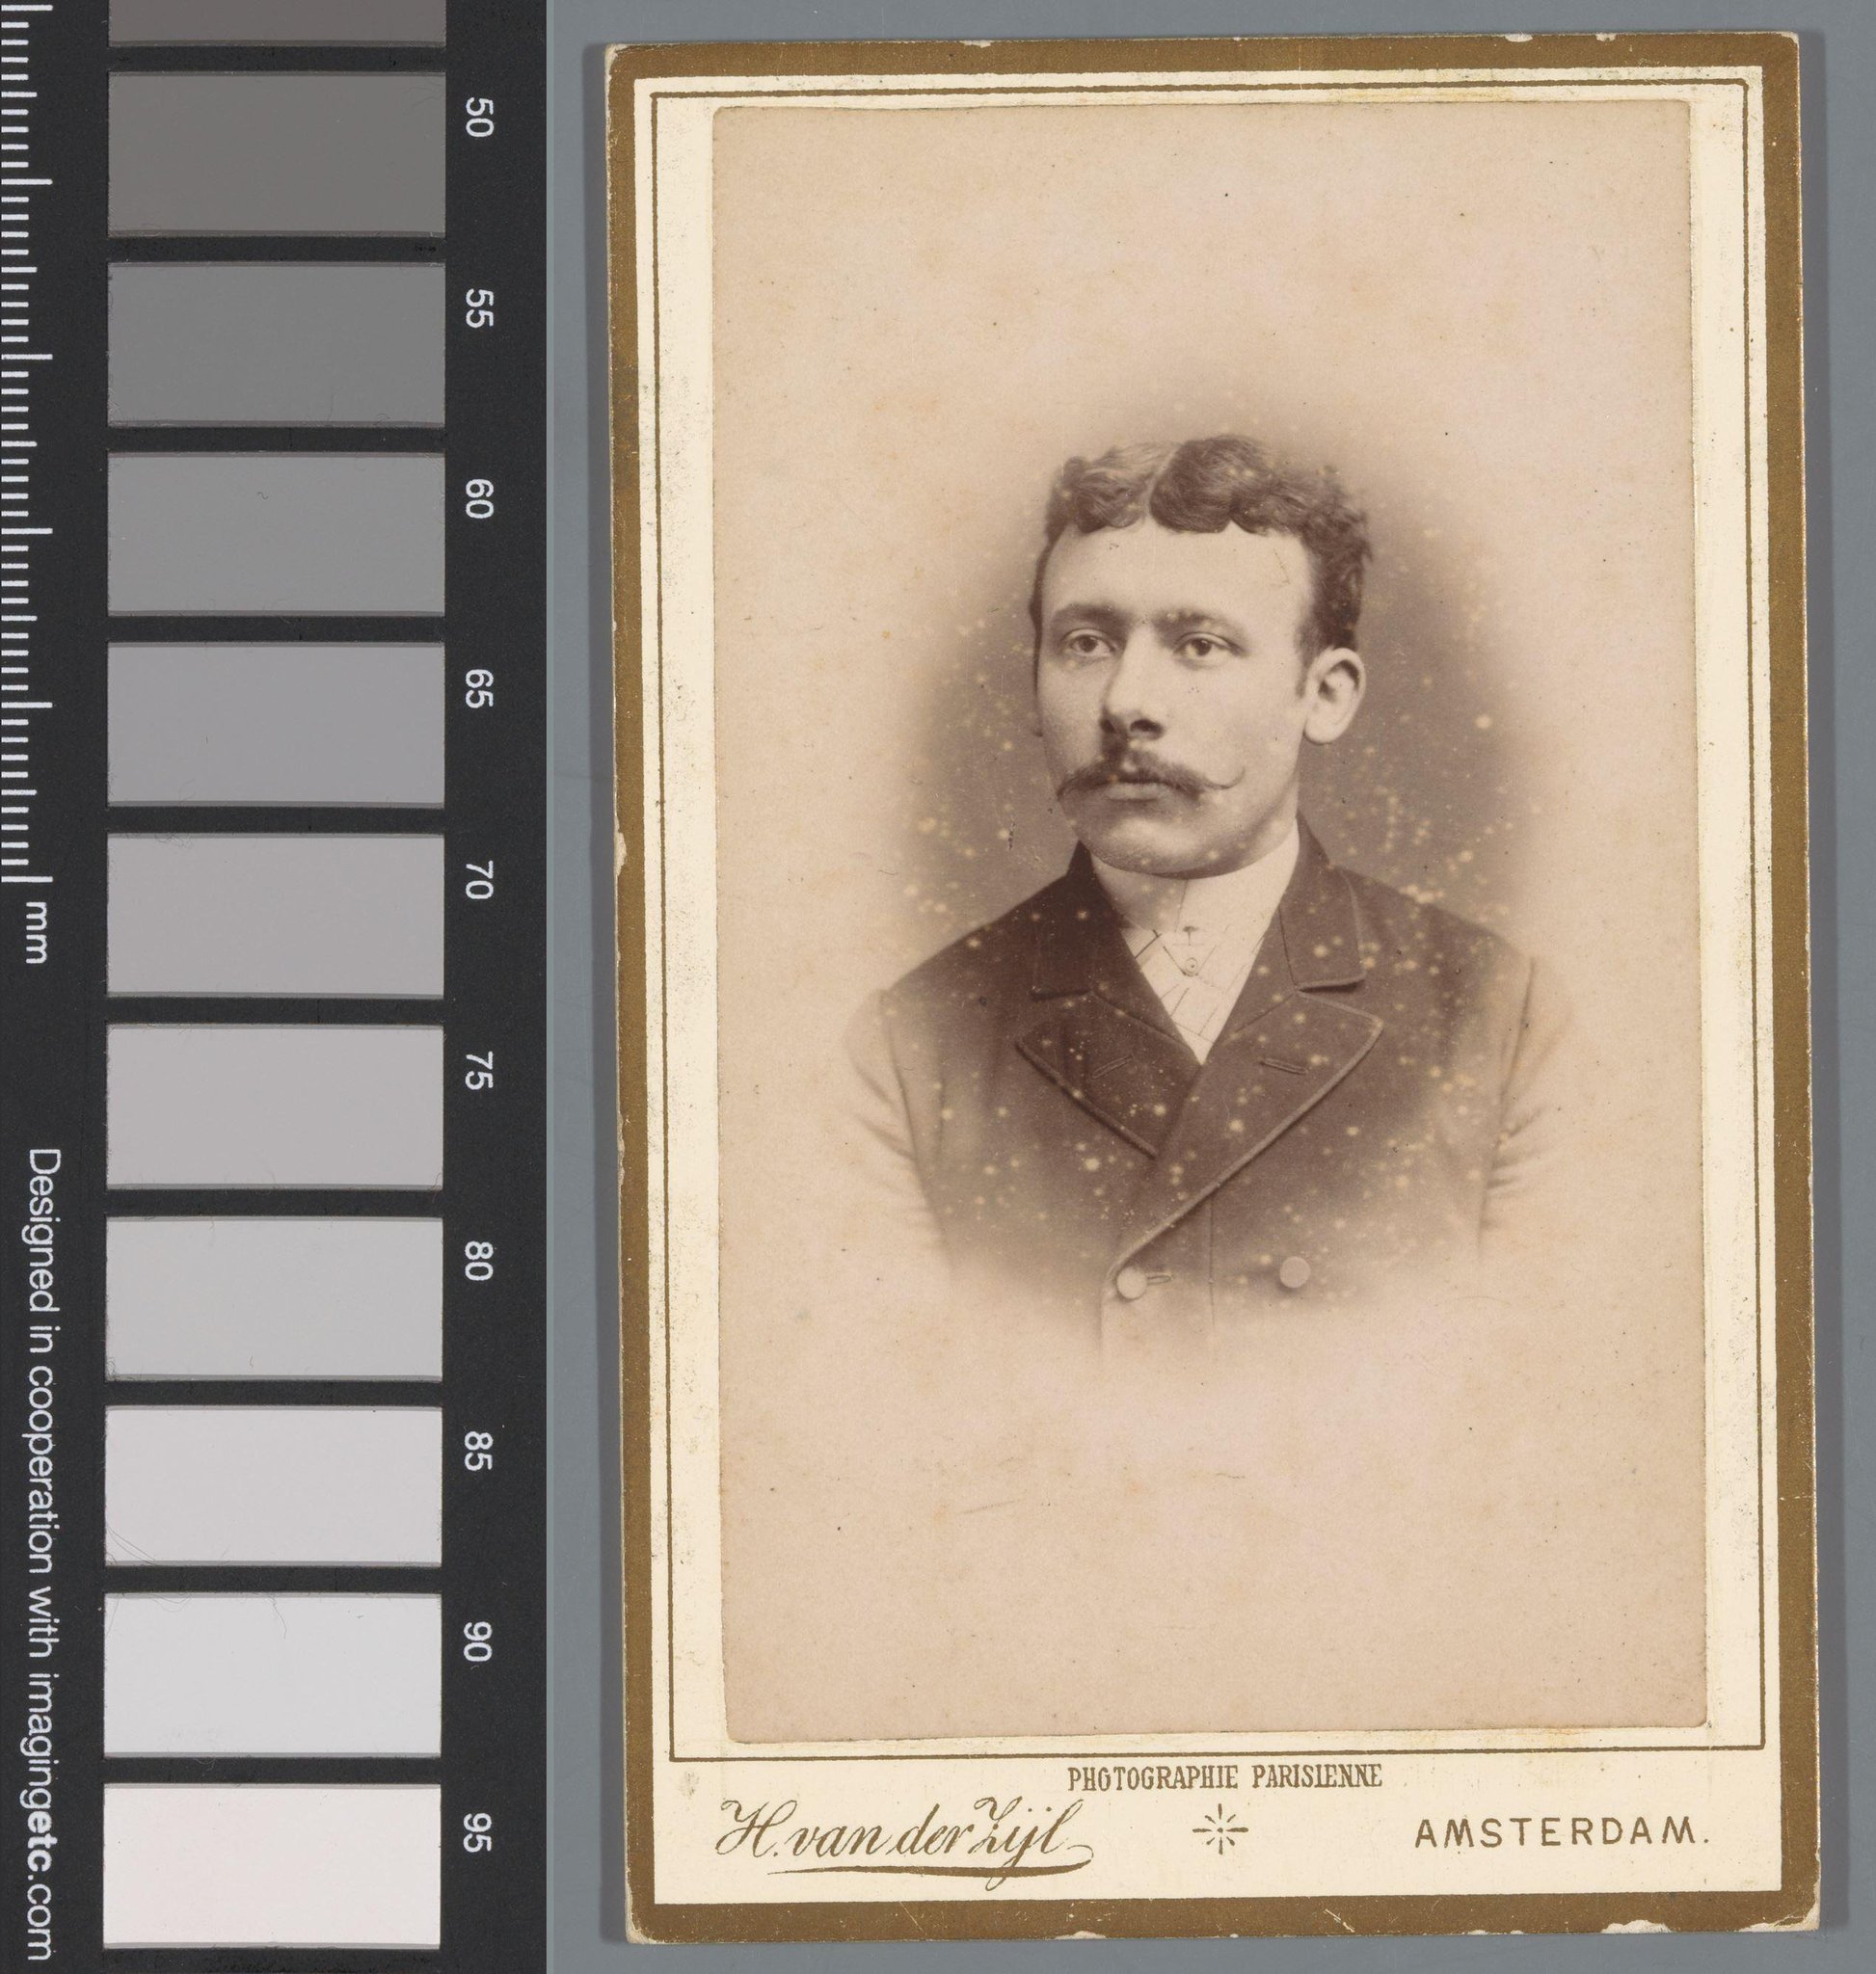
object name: carte de visite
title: Portret van een onbekende man met snor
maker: h. van der zijl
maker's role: fotograaf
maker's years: 1852-1937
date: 1886-1908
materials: cardboard, paper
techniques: albumen print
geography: amsterdam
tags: adult man, anonymous historical person portrayed, amsterdam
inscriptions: inscription: ‘H. van der Zijl/ Photographie Parisienne/ Nieuwendijk 60, over Raamskooi./ Amsterdam/ Portretten in alle Afmetingen, Groepen, Architecturen,/ Fabrieken en andere Gebouwen./ De plaat blijft ter nabestelling bewaard./ Bernhard Wachtl Wien’, inscription: ‘H. van der Zijl/ Photographie Parisienne/ Amsterdam.’